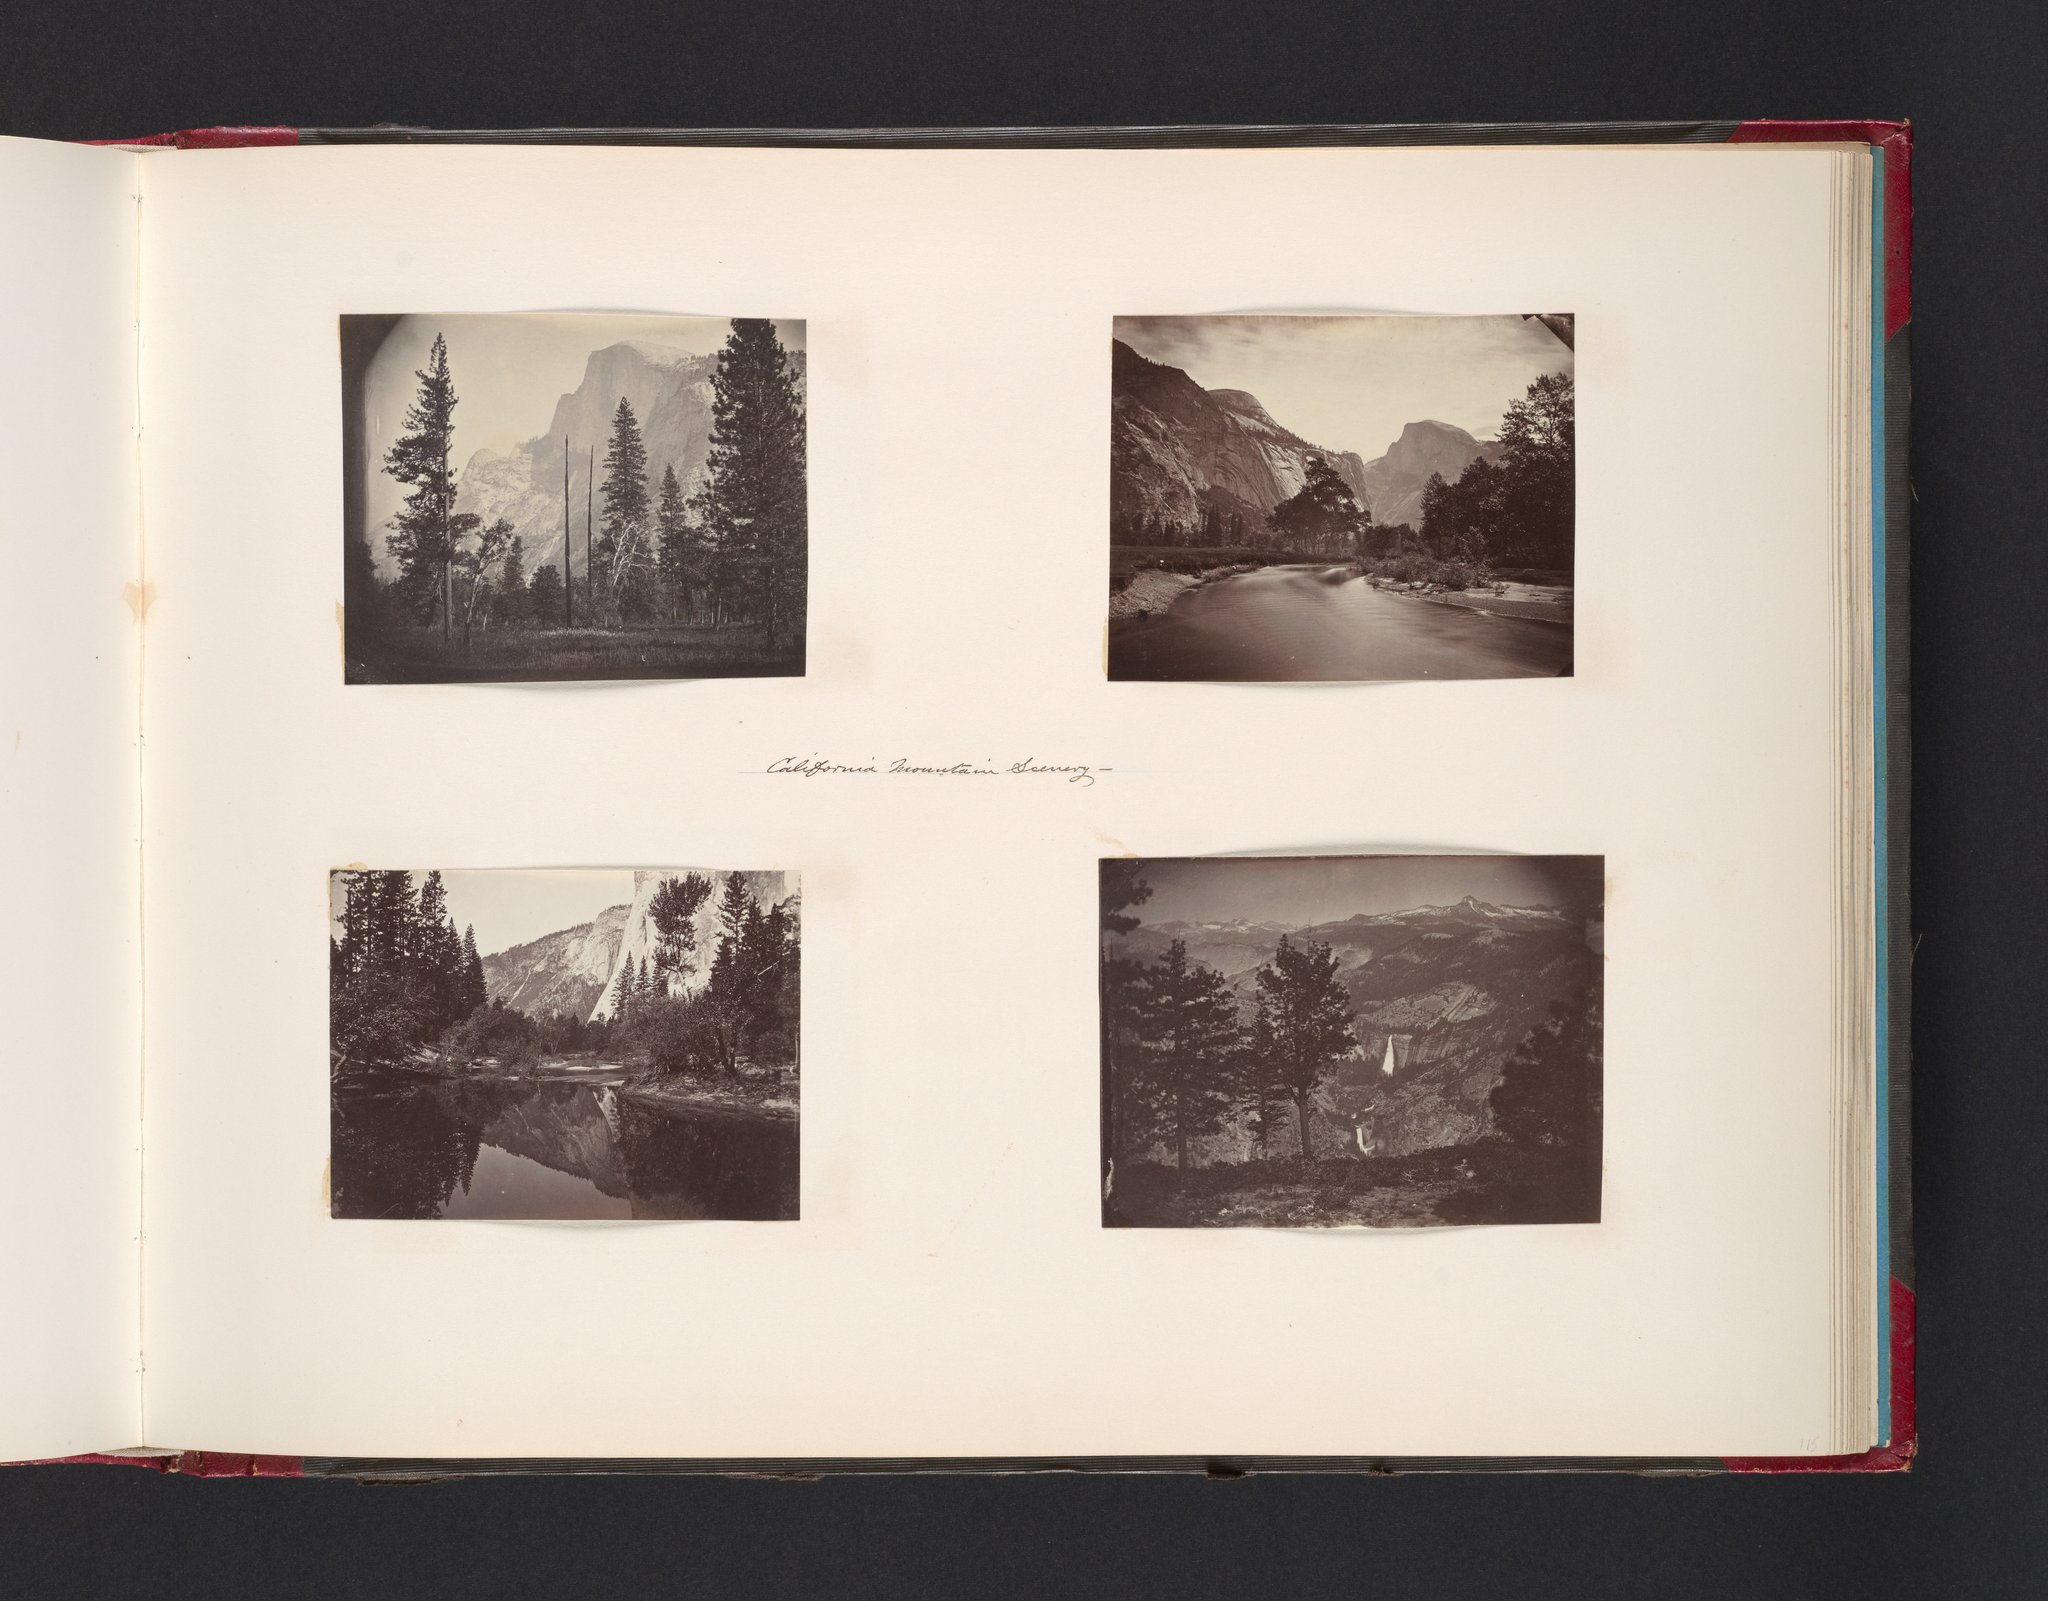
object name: photograph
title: California Mountain Scenery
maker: john thomson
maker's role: artist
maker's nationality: british, scottish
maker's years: 1837-1921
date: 1865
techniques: albumen silver print, glass negative